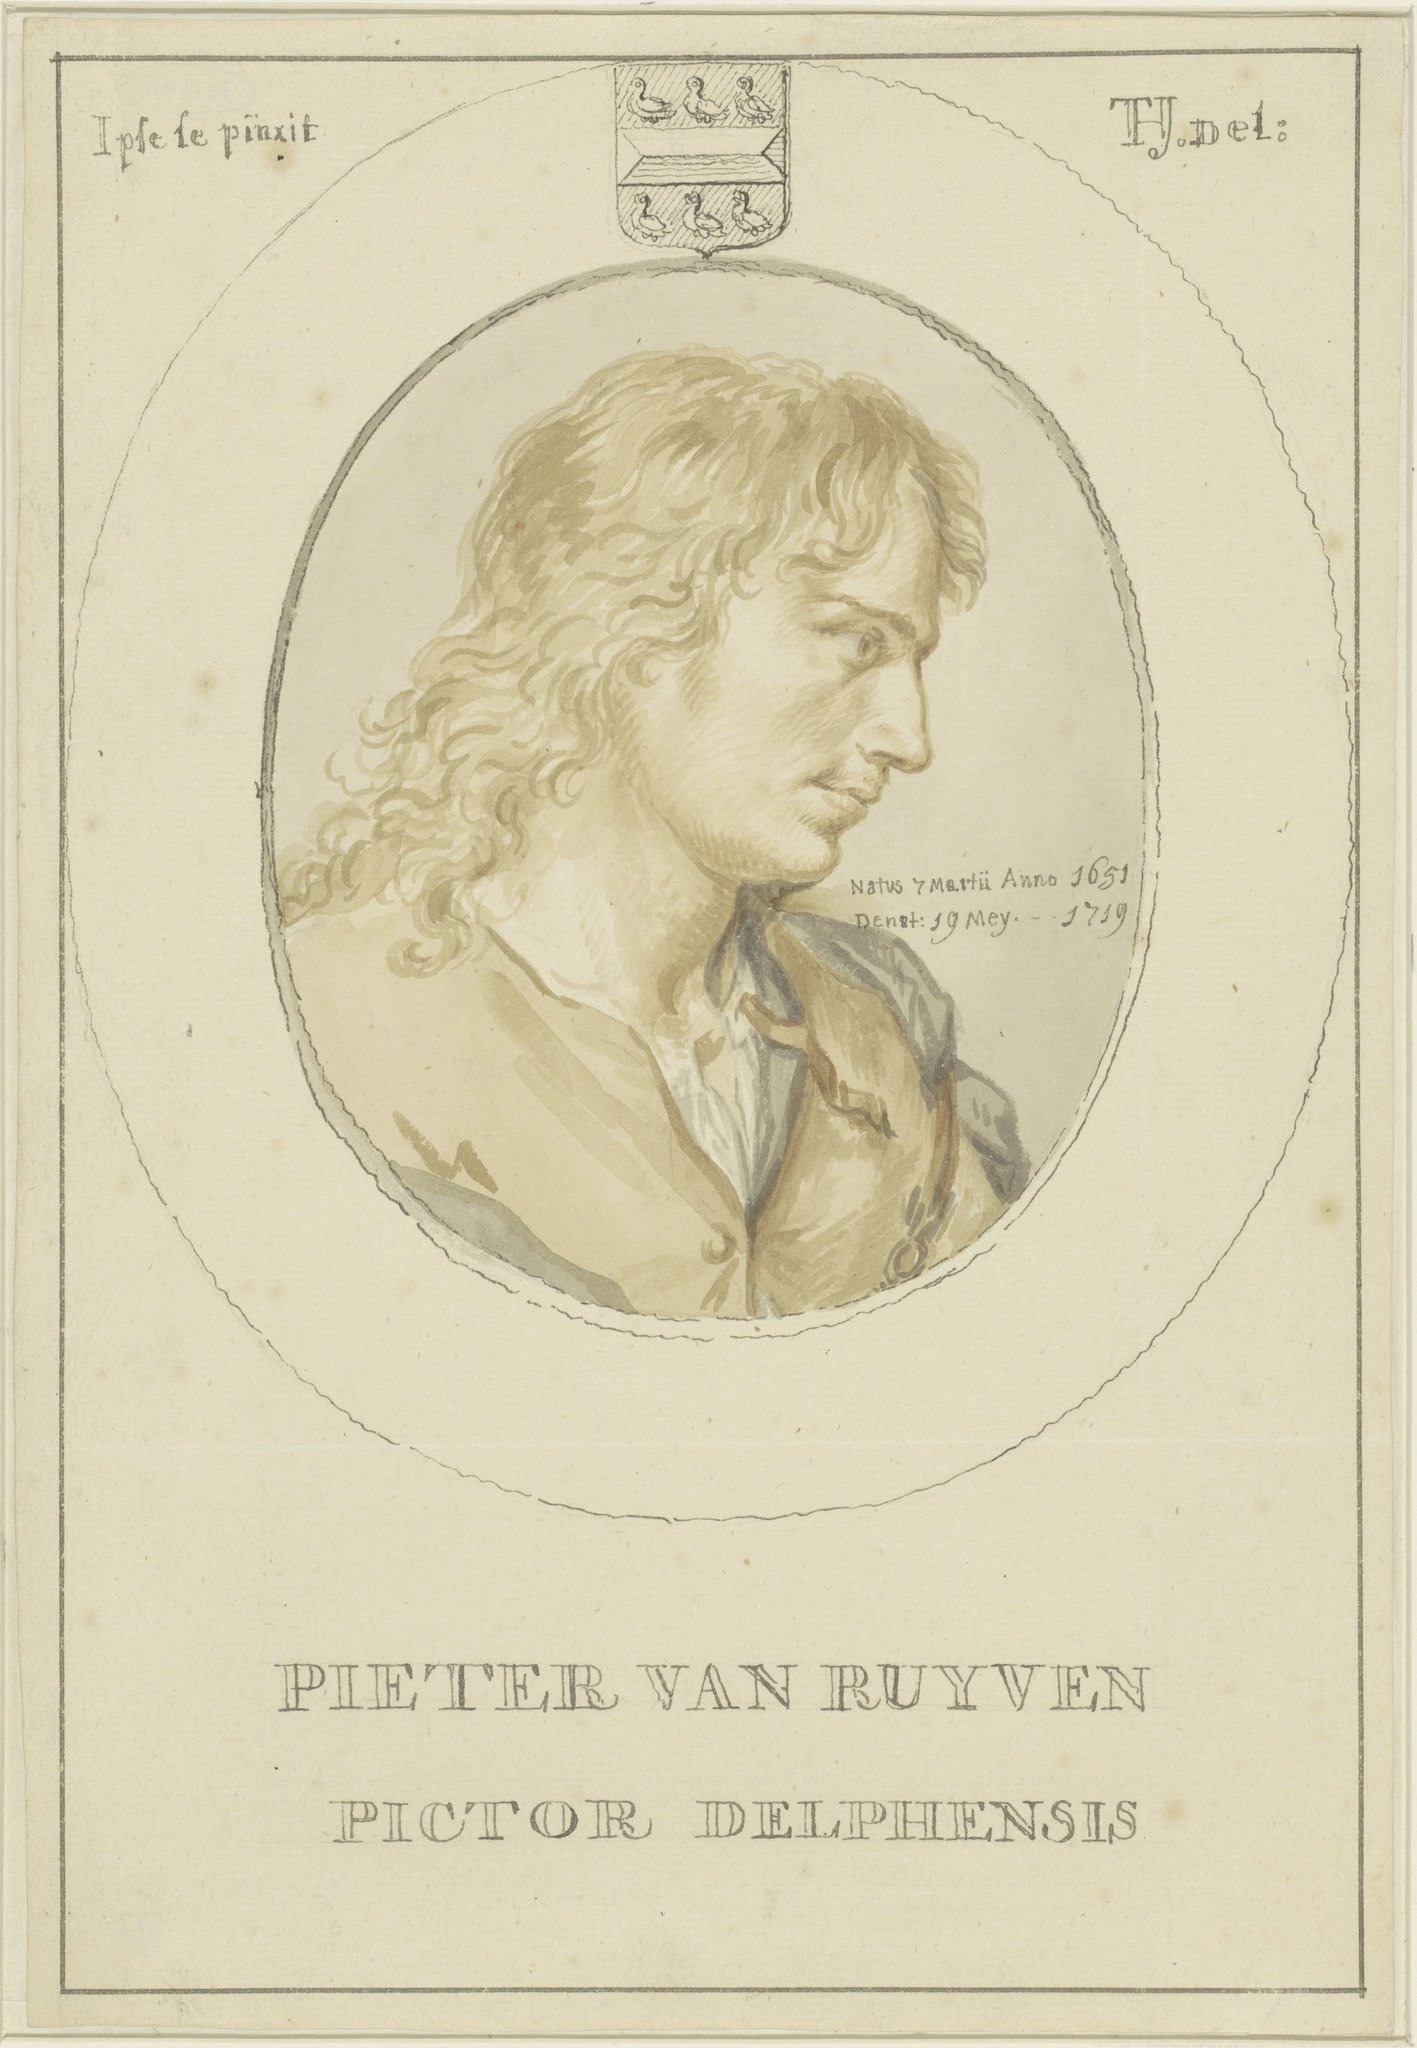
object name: drawing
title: Portret van Pieter van Ruyven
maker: tako hajo jelgersma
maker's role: draughtsman, painter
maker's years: 1702-1795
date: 1712-1795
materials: ink, paper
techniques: brush, pen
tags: delft, print maker, pieter jansz. van ruyven, historical persons, portrait, self-portrait of artist